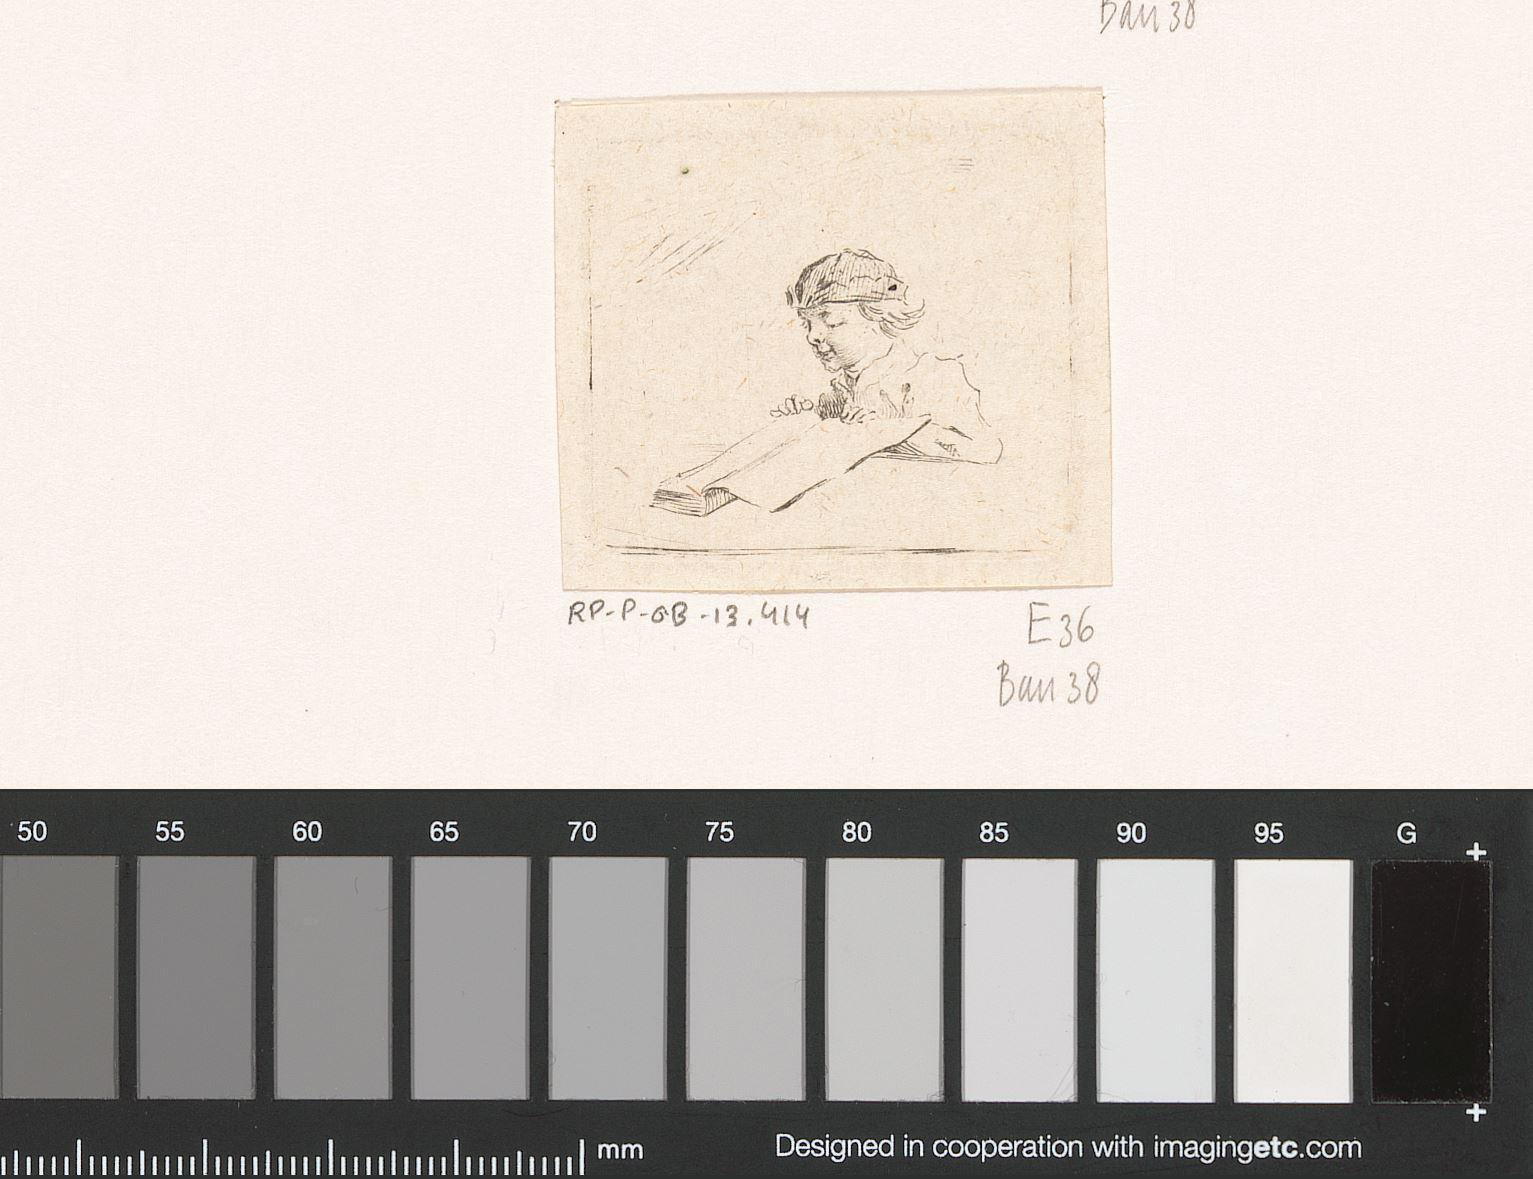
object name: print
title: Lezend kind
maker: daniel nikolaus chodowiecki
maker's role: draughtsman, print maker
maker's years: 1726-1801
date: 1764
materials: paper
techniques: etching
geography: berlin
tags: reading, book - mm - book open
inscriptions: collector's mark: Lugt 2228